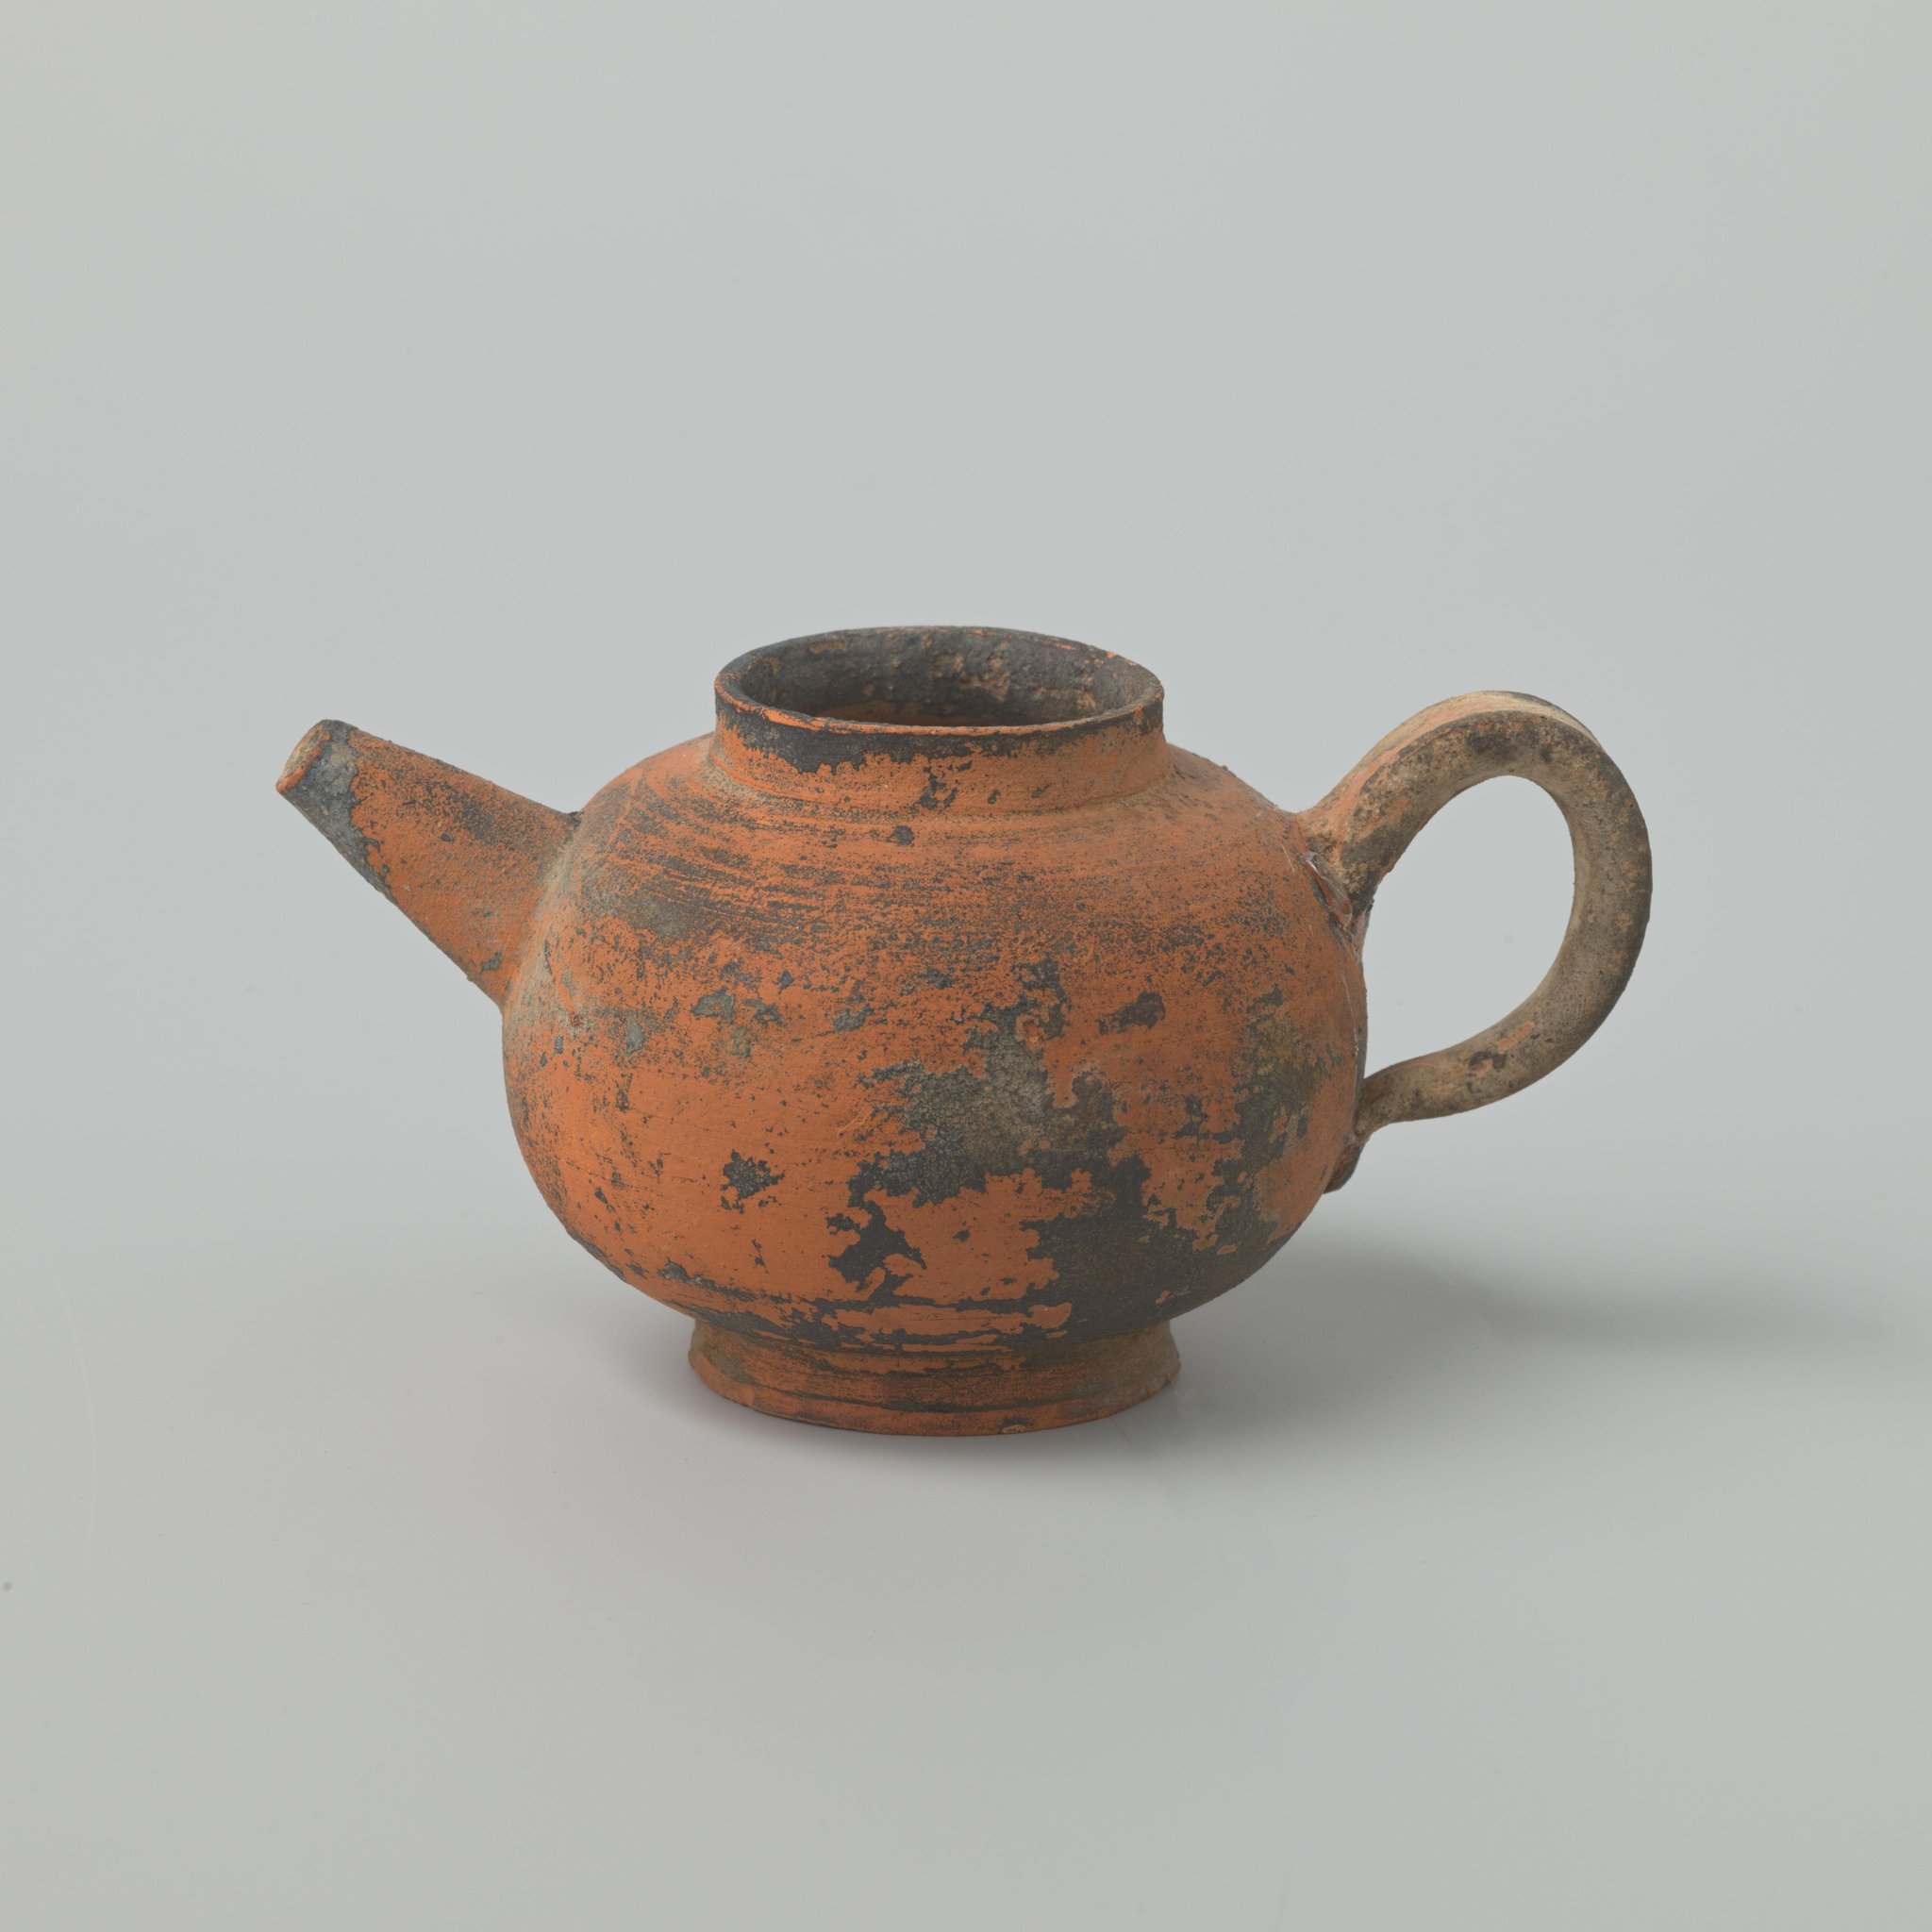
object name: bakafval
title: Theepot van ongeglazuurd aardewerk (De Caluwe bakafval)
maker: jacobus de caluwe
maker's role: plateelbakkerij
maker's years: -1730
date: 1700-1725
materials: earthenware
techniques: firing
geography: delft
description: Toegeschreven aan Jacobus de Caluwe, omdat dit voorwerp samen met gemerkte stukken (‘Jacobus De Caluwe’ en rennend hert) gevonden is op de plaats waar zich De Caluwes tweede werkplaats bevond. Er is een duidelijke stilistische overeenkomst tussen de gemerkte en niet gemerkte voorwerpen uit deze archeologische vondst.